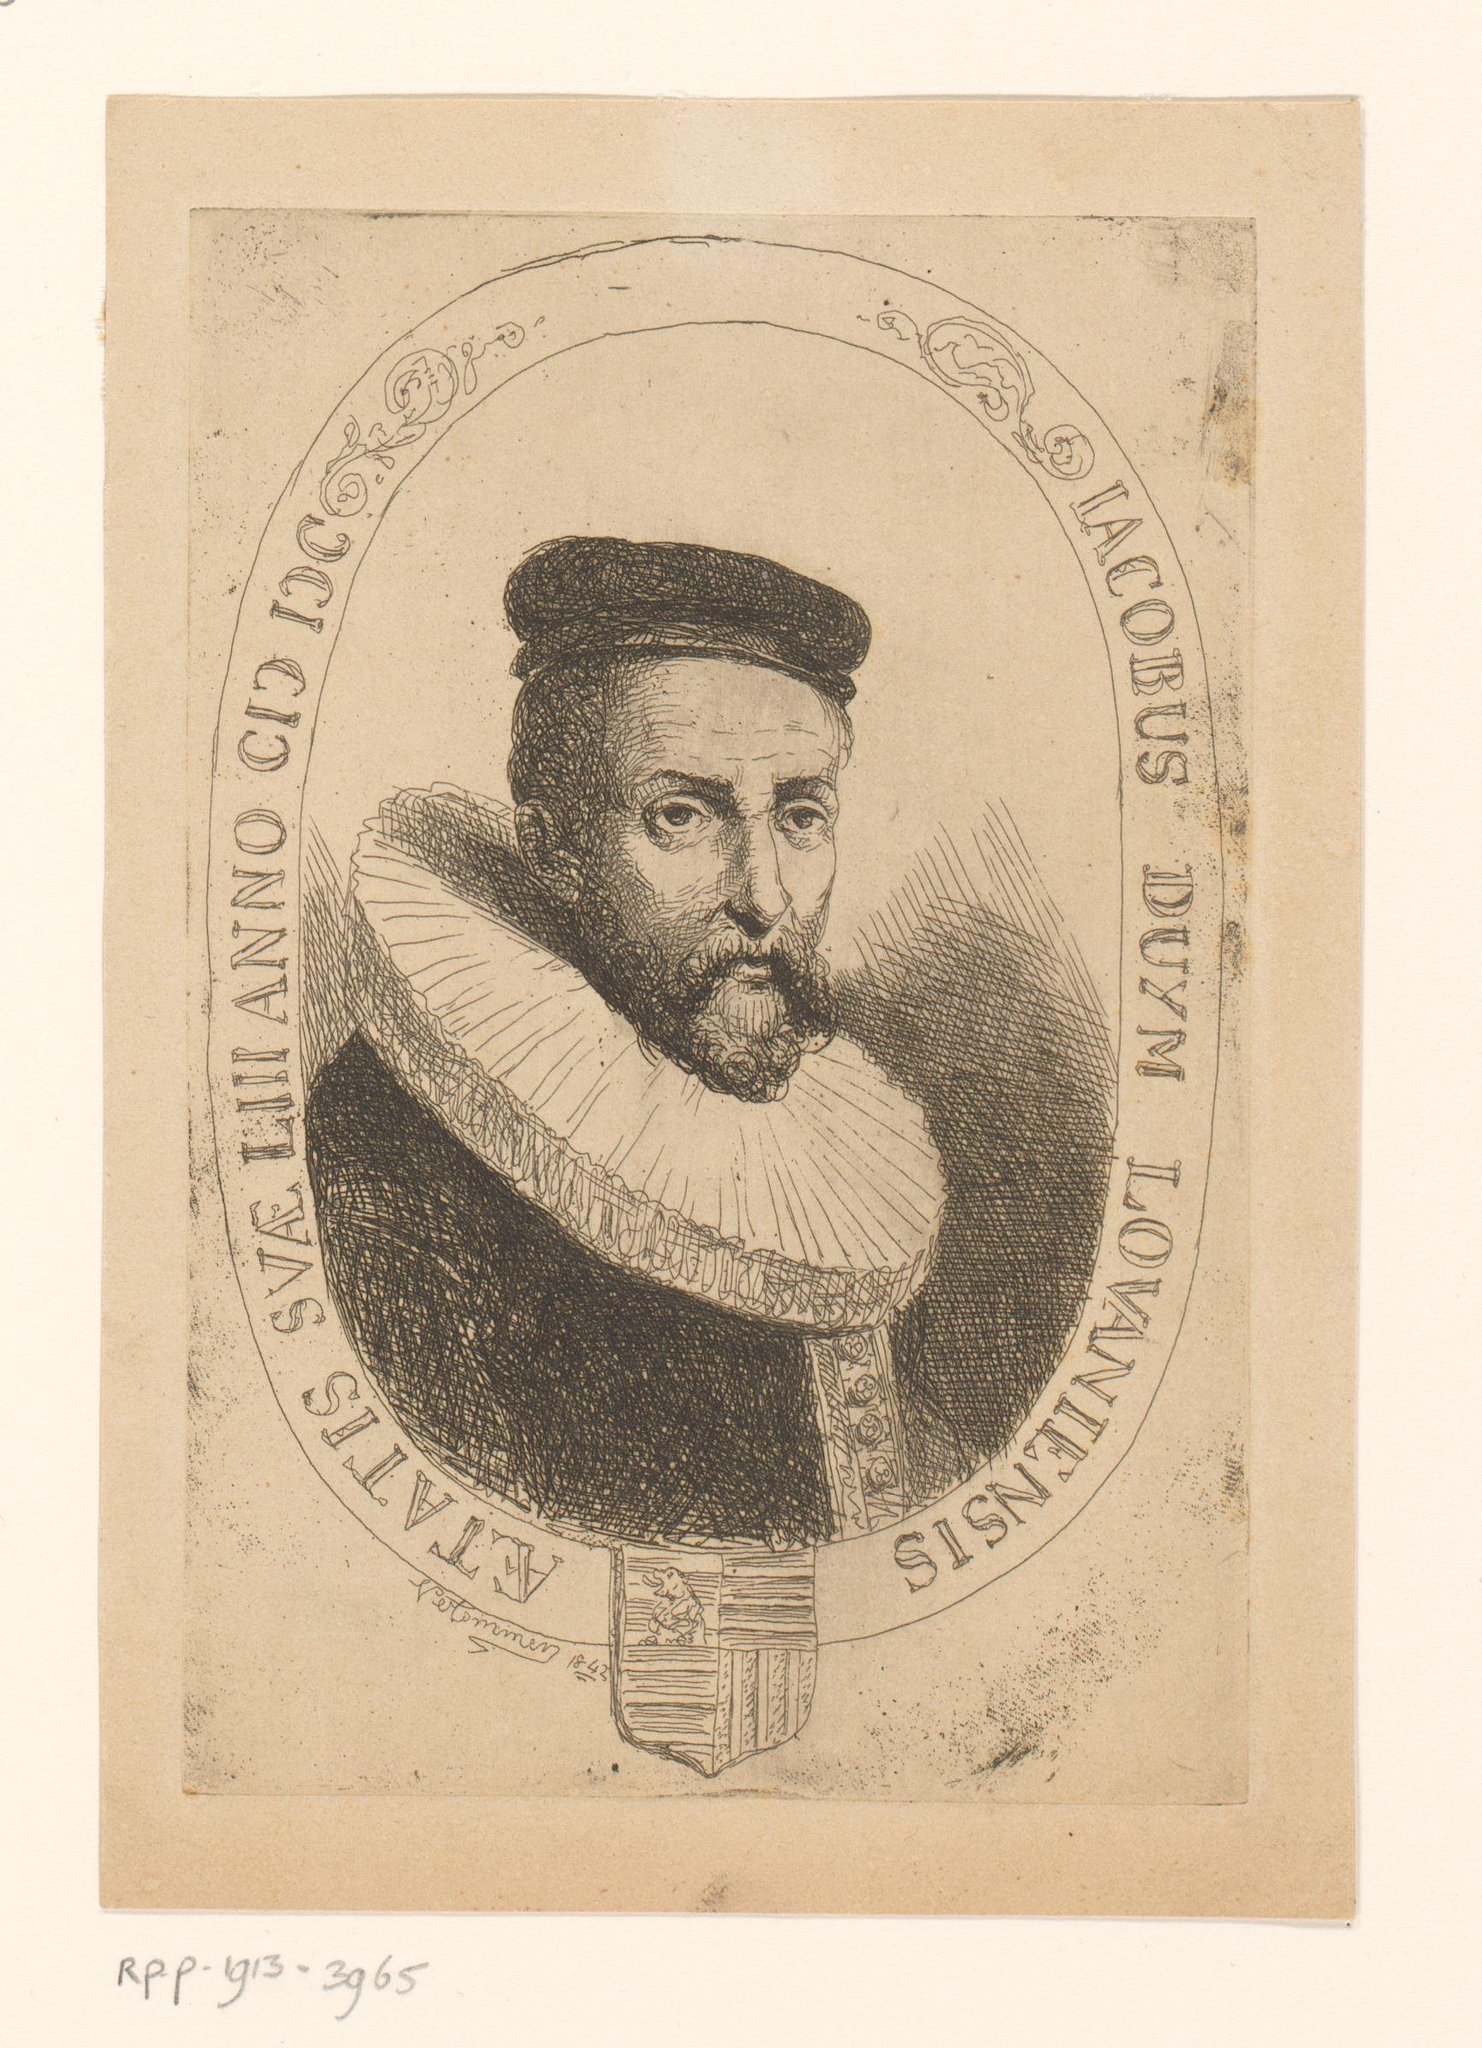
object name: print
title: Portret van Jacob Duym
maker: guillaume joseph vertommen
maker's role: print maker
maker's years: 1815-1863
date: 1842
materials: paper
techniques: etching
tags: louvain, historical persons, beard, armorial bearing, heraldry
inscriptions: collector's mark: Lugt 2228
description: Rondom het portret de tekst: Iacobus Duym Lovaniensis aetatis suae LIII anno [...]. Midden onder het familiewapen.